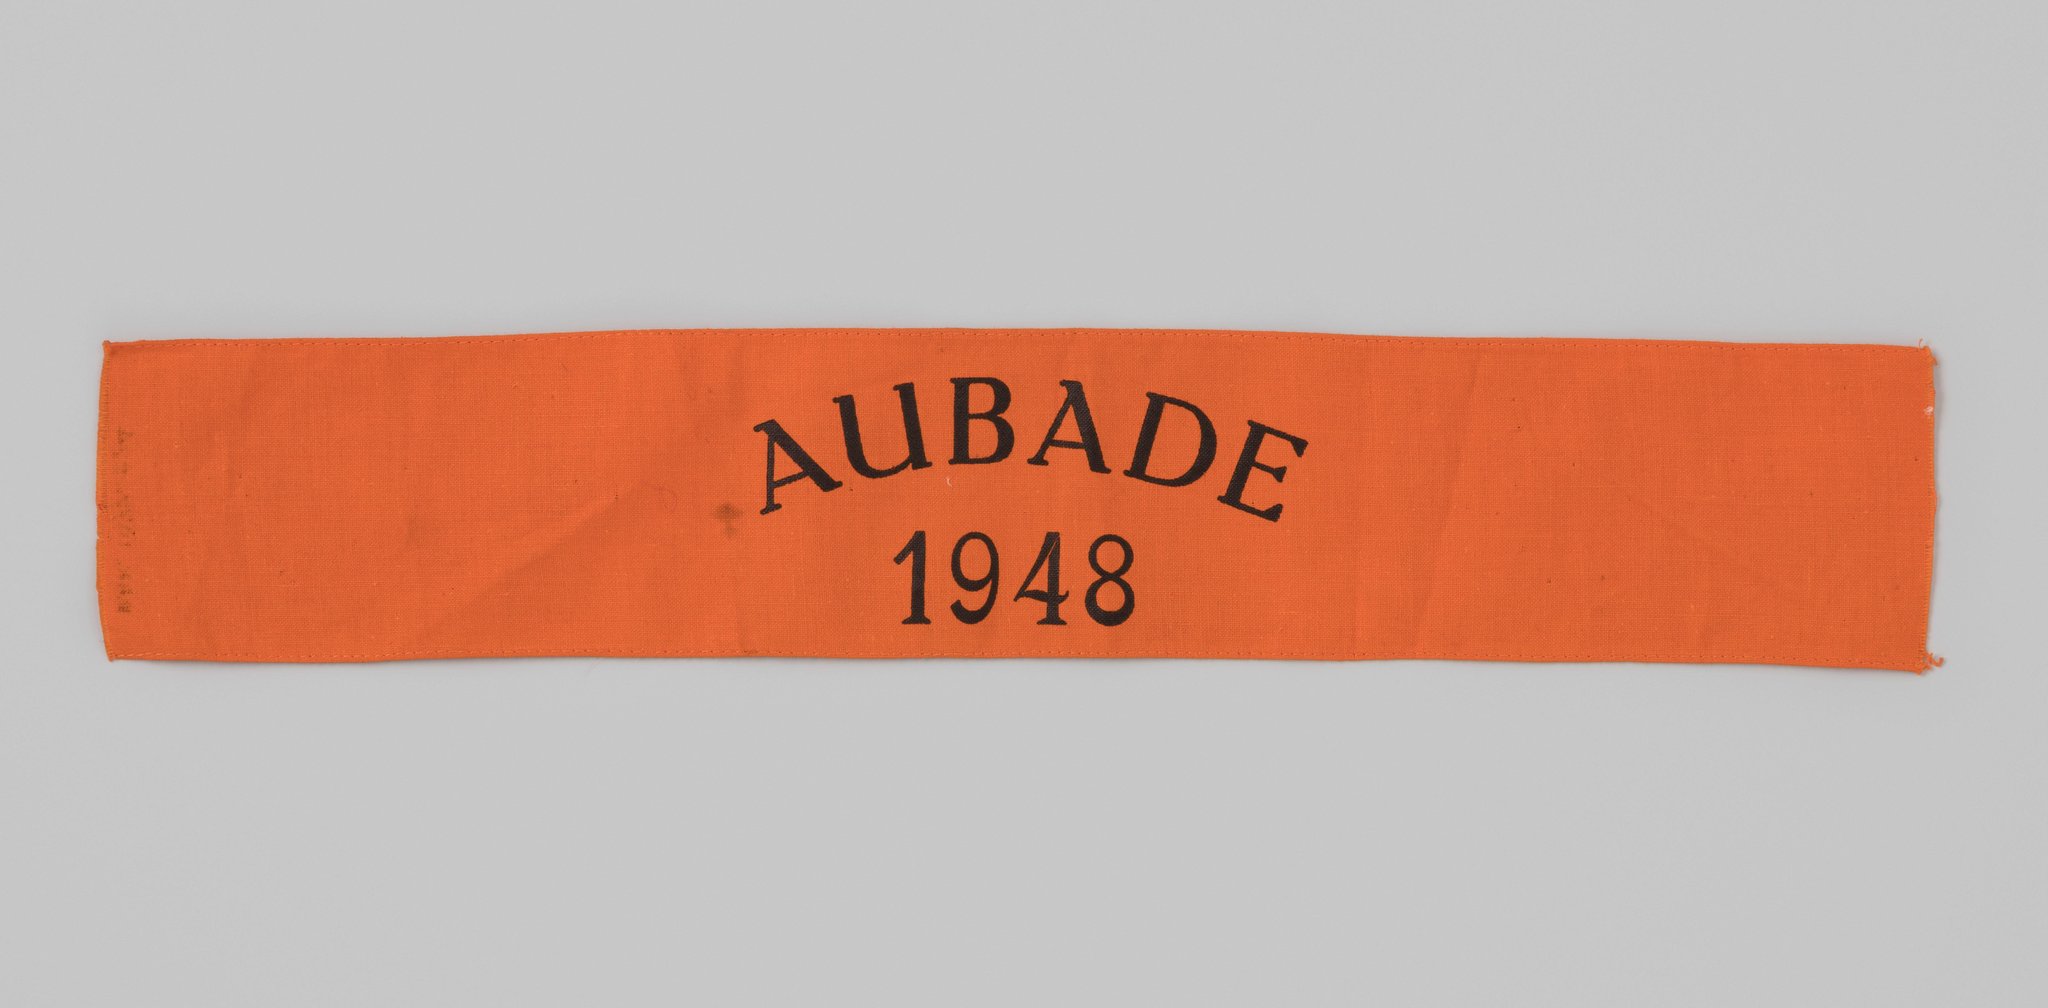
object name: ribbon material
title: Lint van oranje katoen, met daarop in zwart de gedrukte tekst 'Aubade // 1948'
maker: Anonymous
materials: cotton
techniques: printing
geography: netherlands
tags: the hague, print maker, wilhelmina of the netherlands, netherlands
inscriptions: inscription: ‘AUBADE // 1948’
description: Armlint van oranje katoen, met daarop in zwart de gedrukte tekst 'Aubade // 1948'.